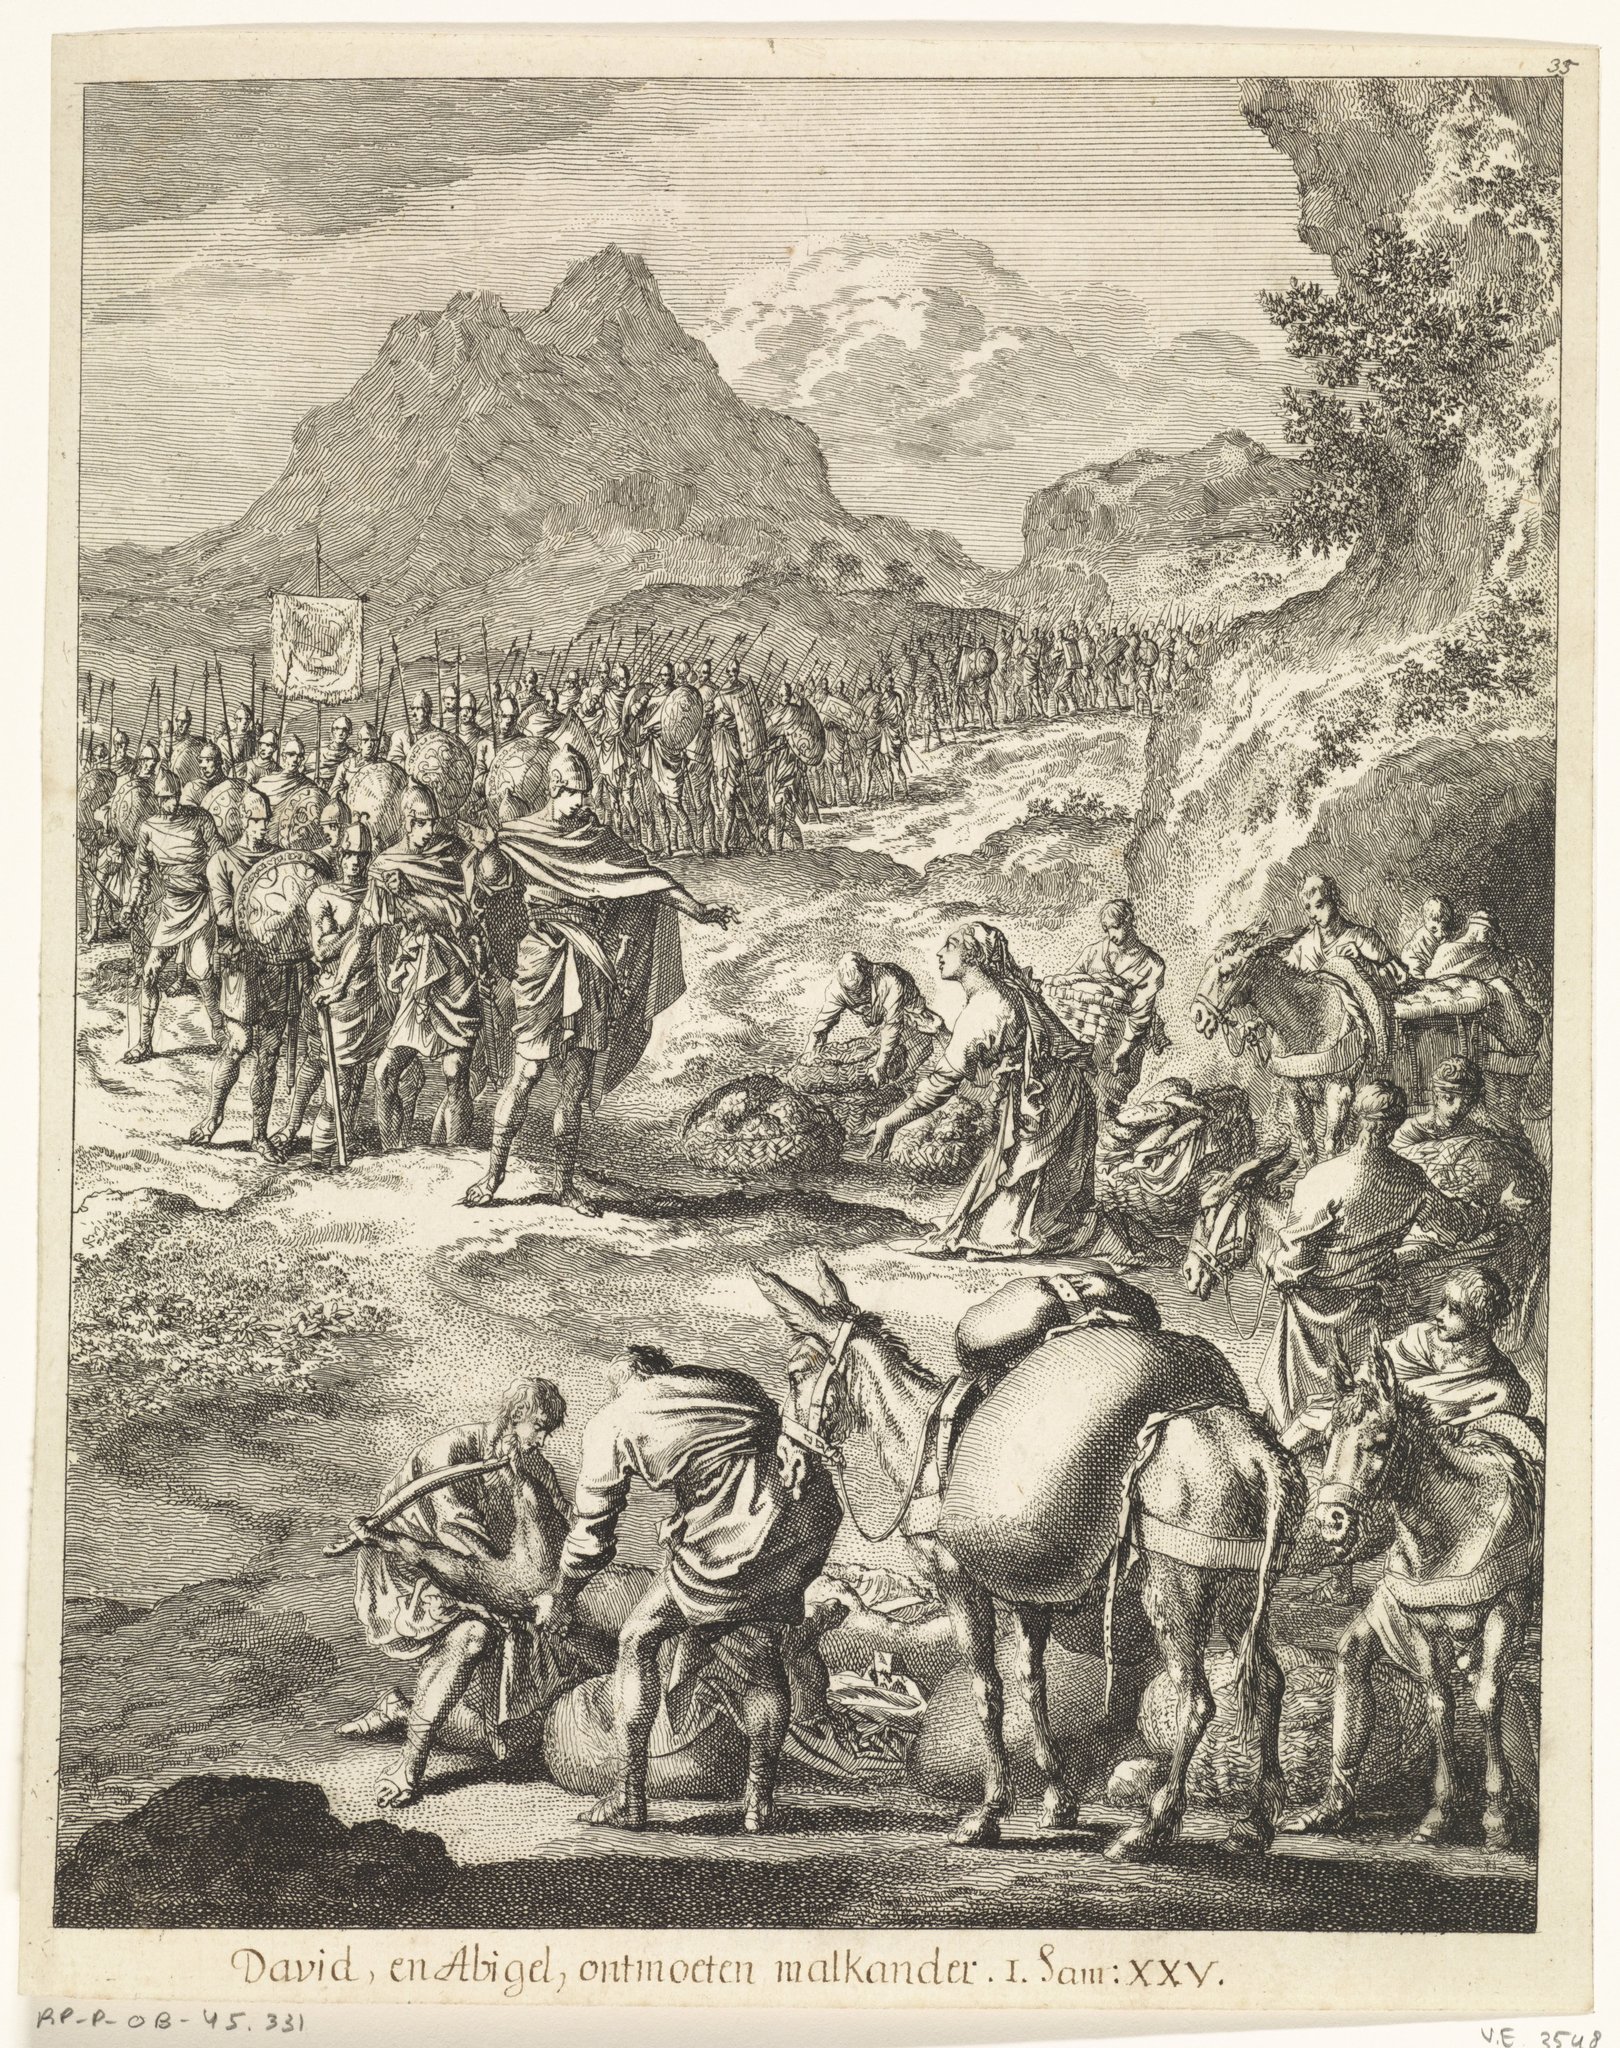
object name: print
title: Ontmoeting van David en Abigaïl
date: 1708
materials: paper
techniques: etching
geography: amsterdam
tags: meeting of david and abigail, who kneels before him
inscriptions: collector's mark: Lugt 2228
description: Proefdruk van een prent welke is opgenomen als illustratie in: Historiae Celebriores Veteris Testamenti. Christoph Weigel, 1708.